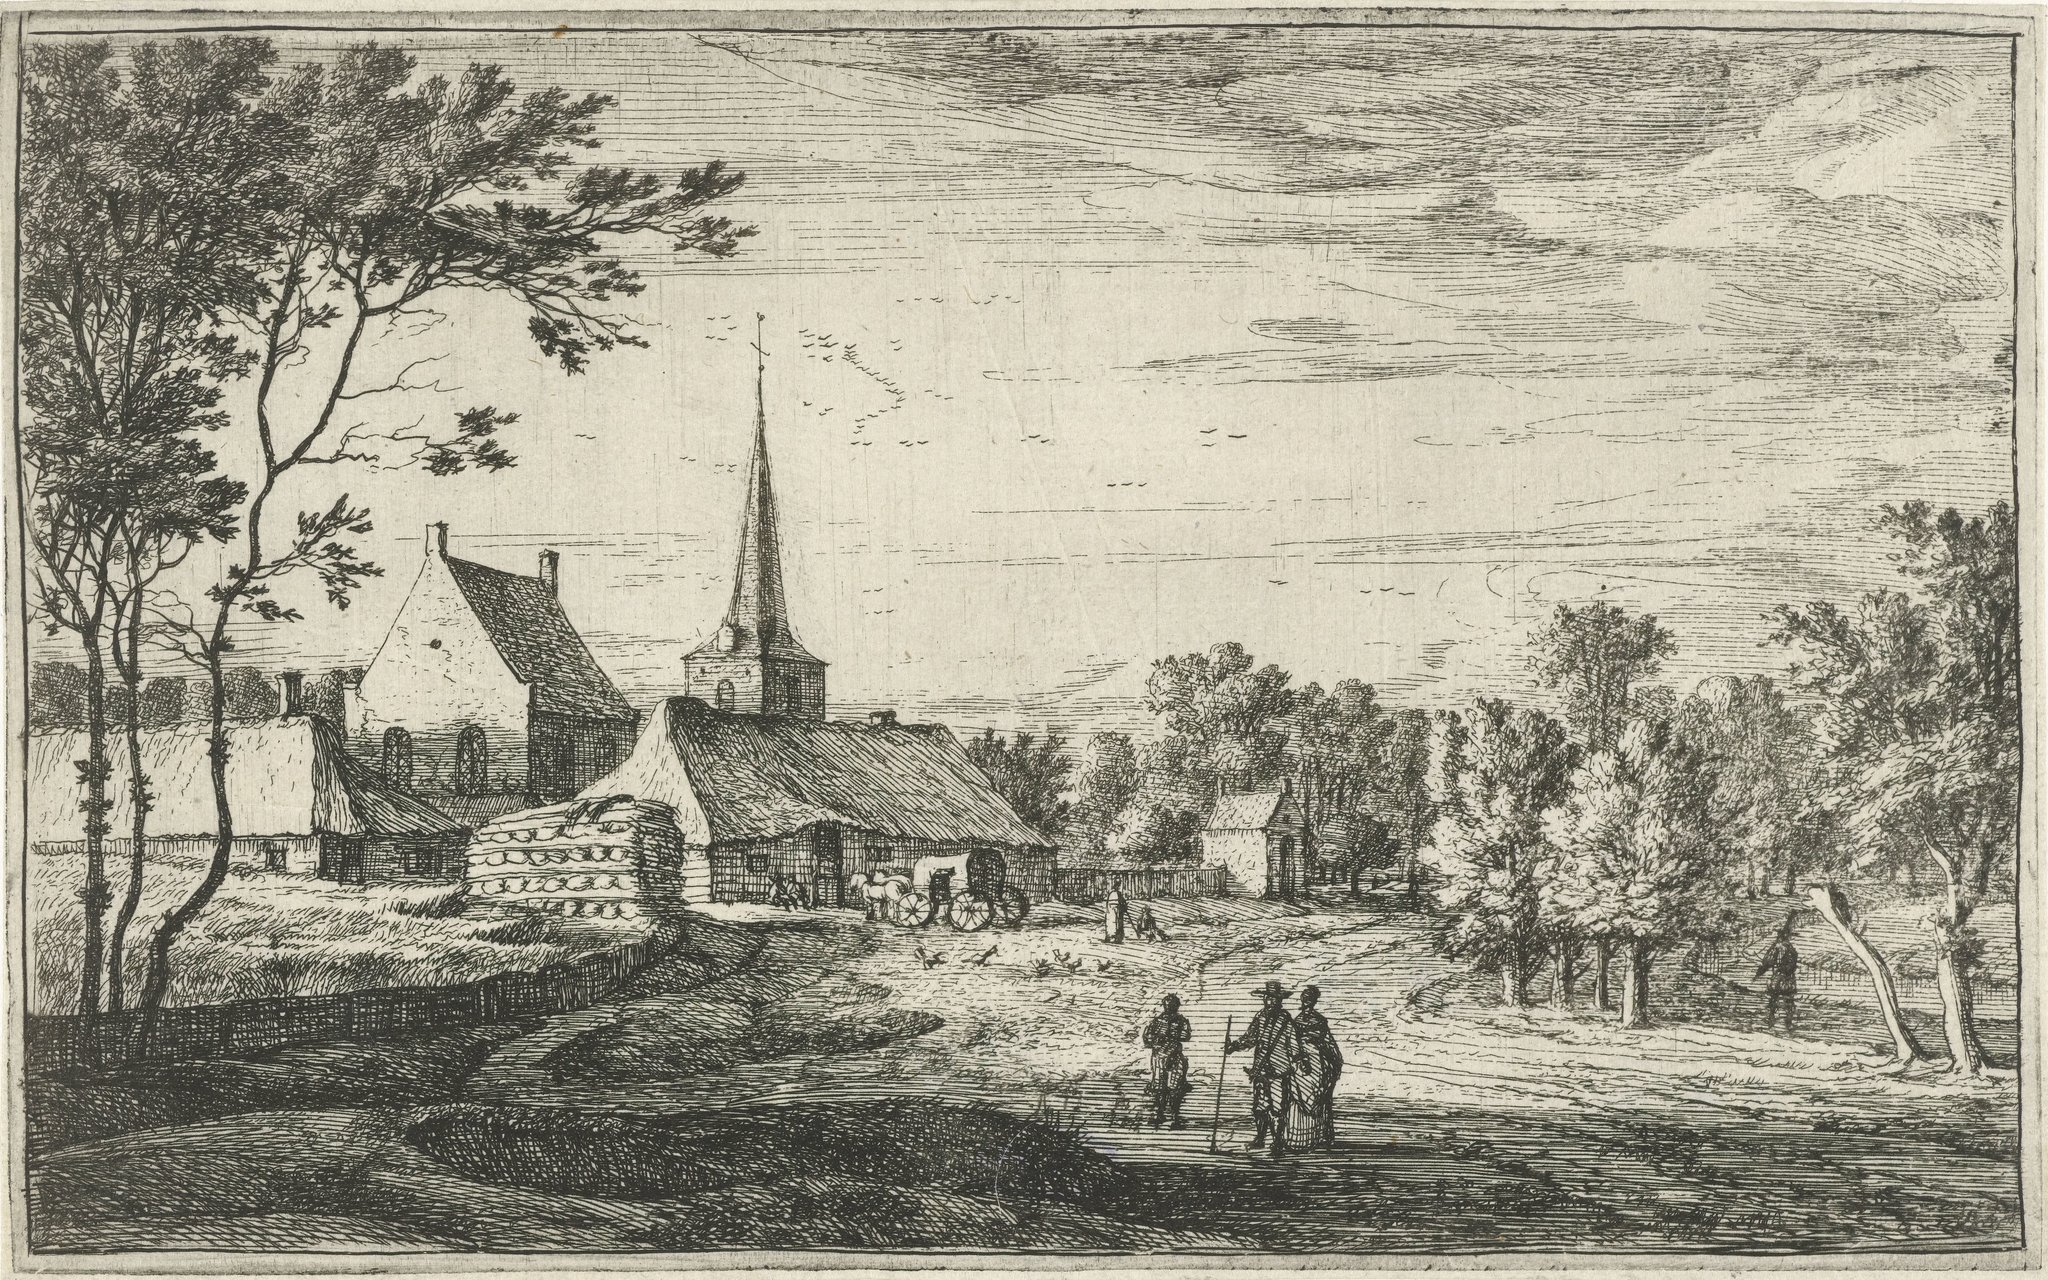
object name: print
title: Gezicht op Heesbeen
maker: roelant roghman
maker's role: draughtsman, painter, print maker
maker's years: 1627-1692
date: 1643-1677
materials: paper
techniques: etching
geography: amsterdam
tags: prospect of village, silhouette of village, church (exterior)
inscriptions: collector's mark: Lugt 2228a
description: Gezicht op het dorp Heesbeen bij Heusden. Links het dorp met de kerk en op de voorgrond enkele passanten.